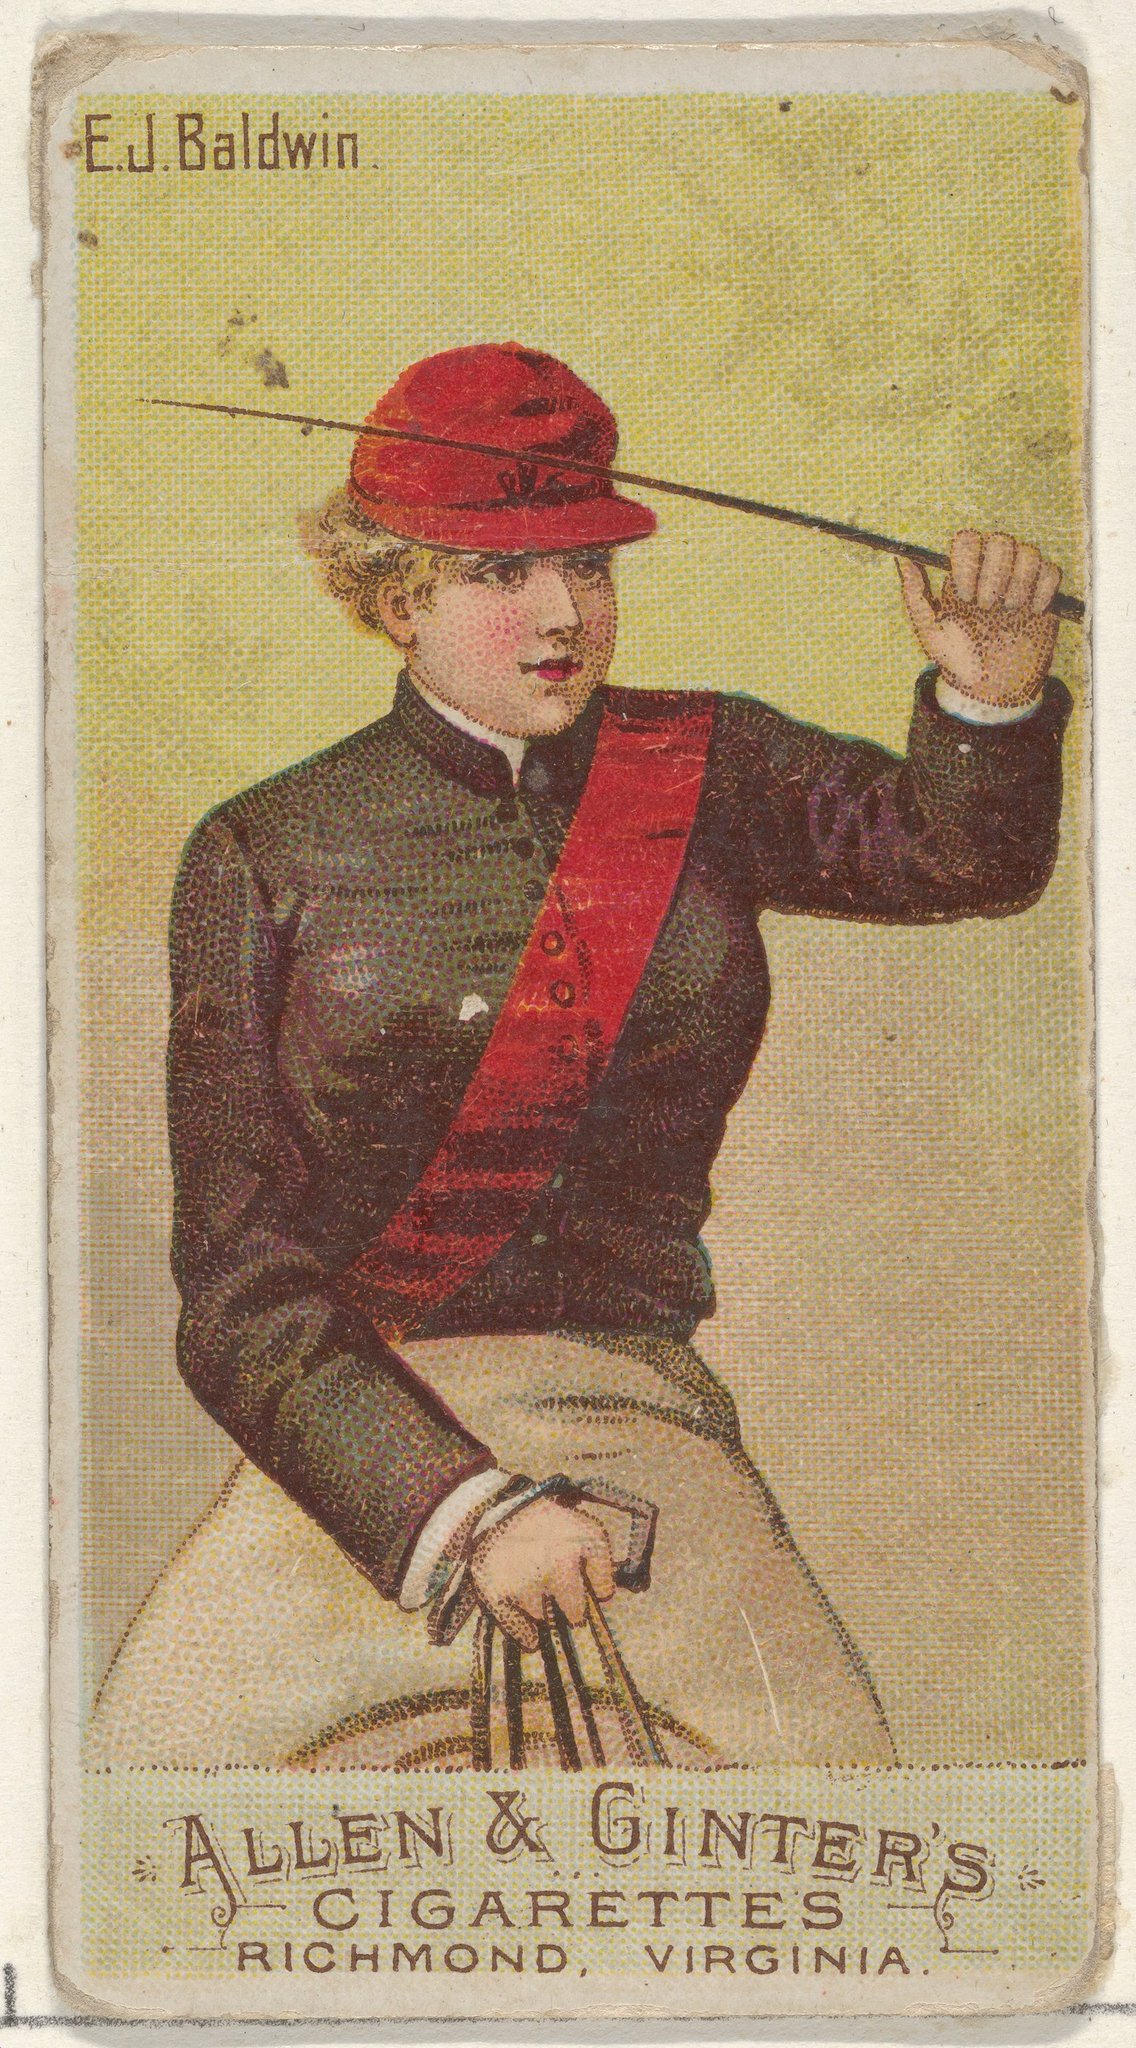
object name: print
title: E.J. Baldwin, from the Racing Colors of the World series (N22a) for Allen & Ginter Cigarettes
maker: allen & ginter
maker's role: publisher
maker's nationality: american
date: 1888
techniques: color lithograph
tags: women,jockeys